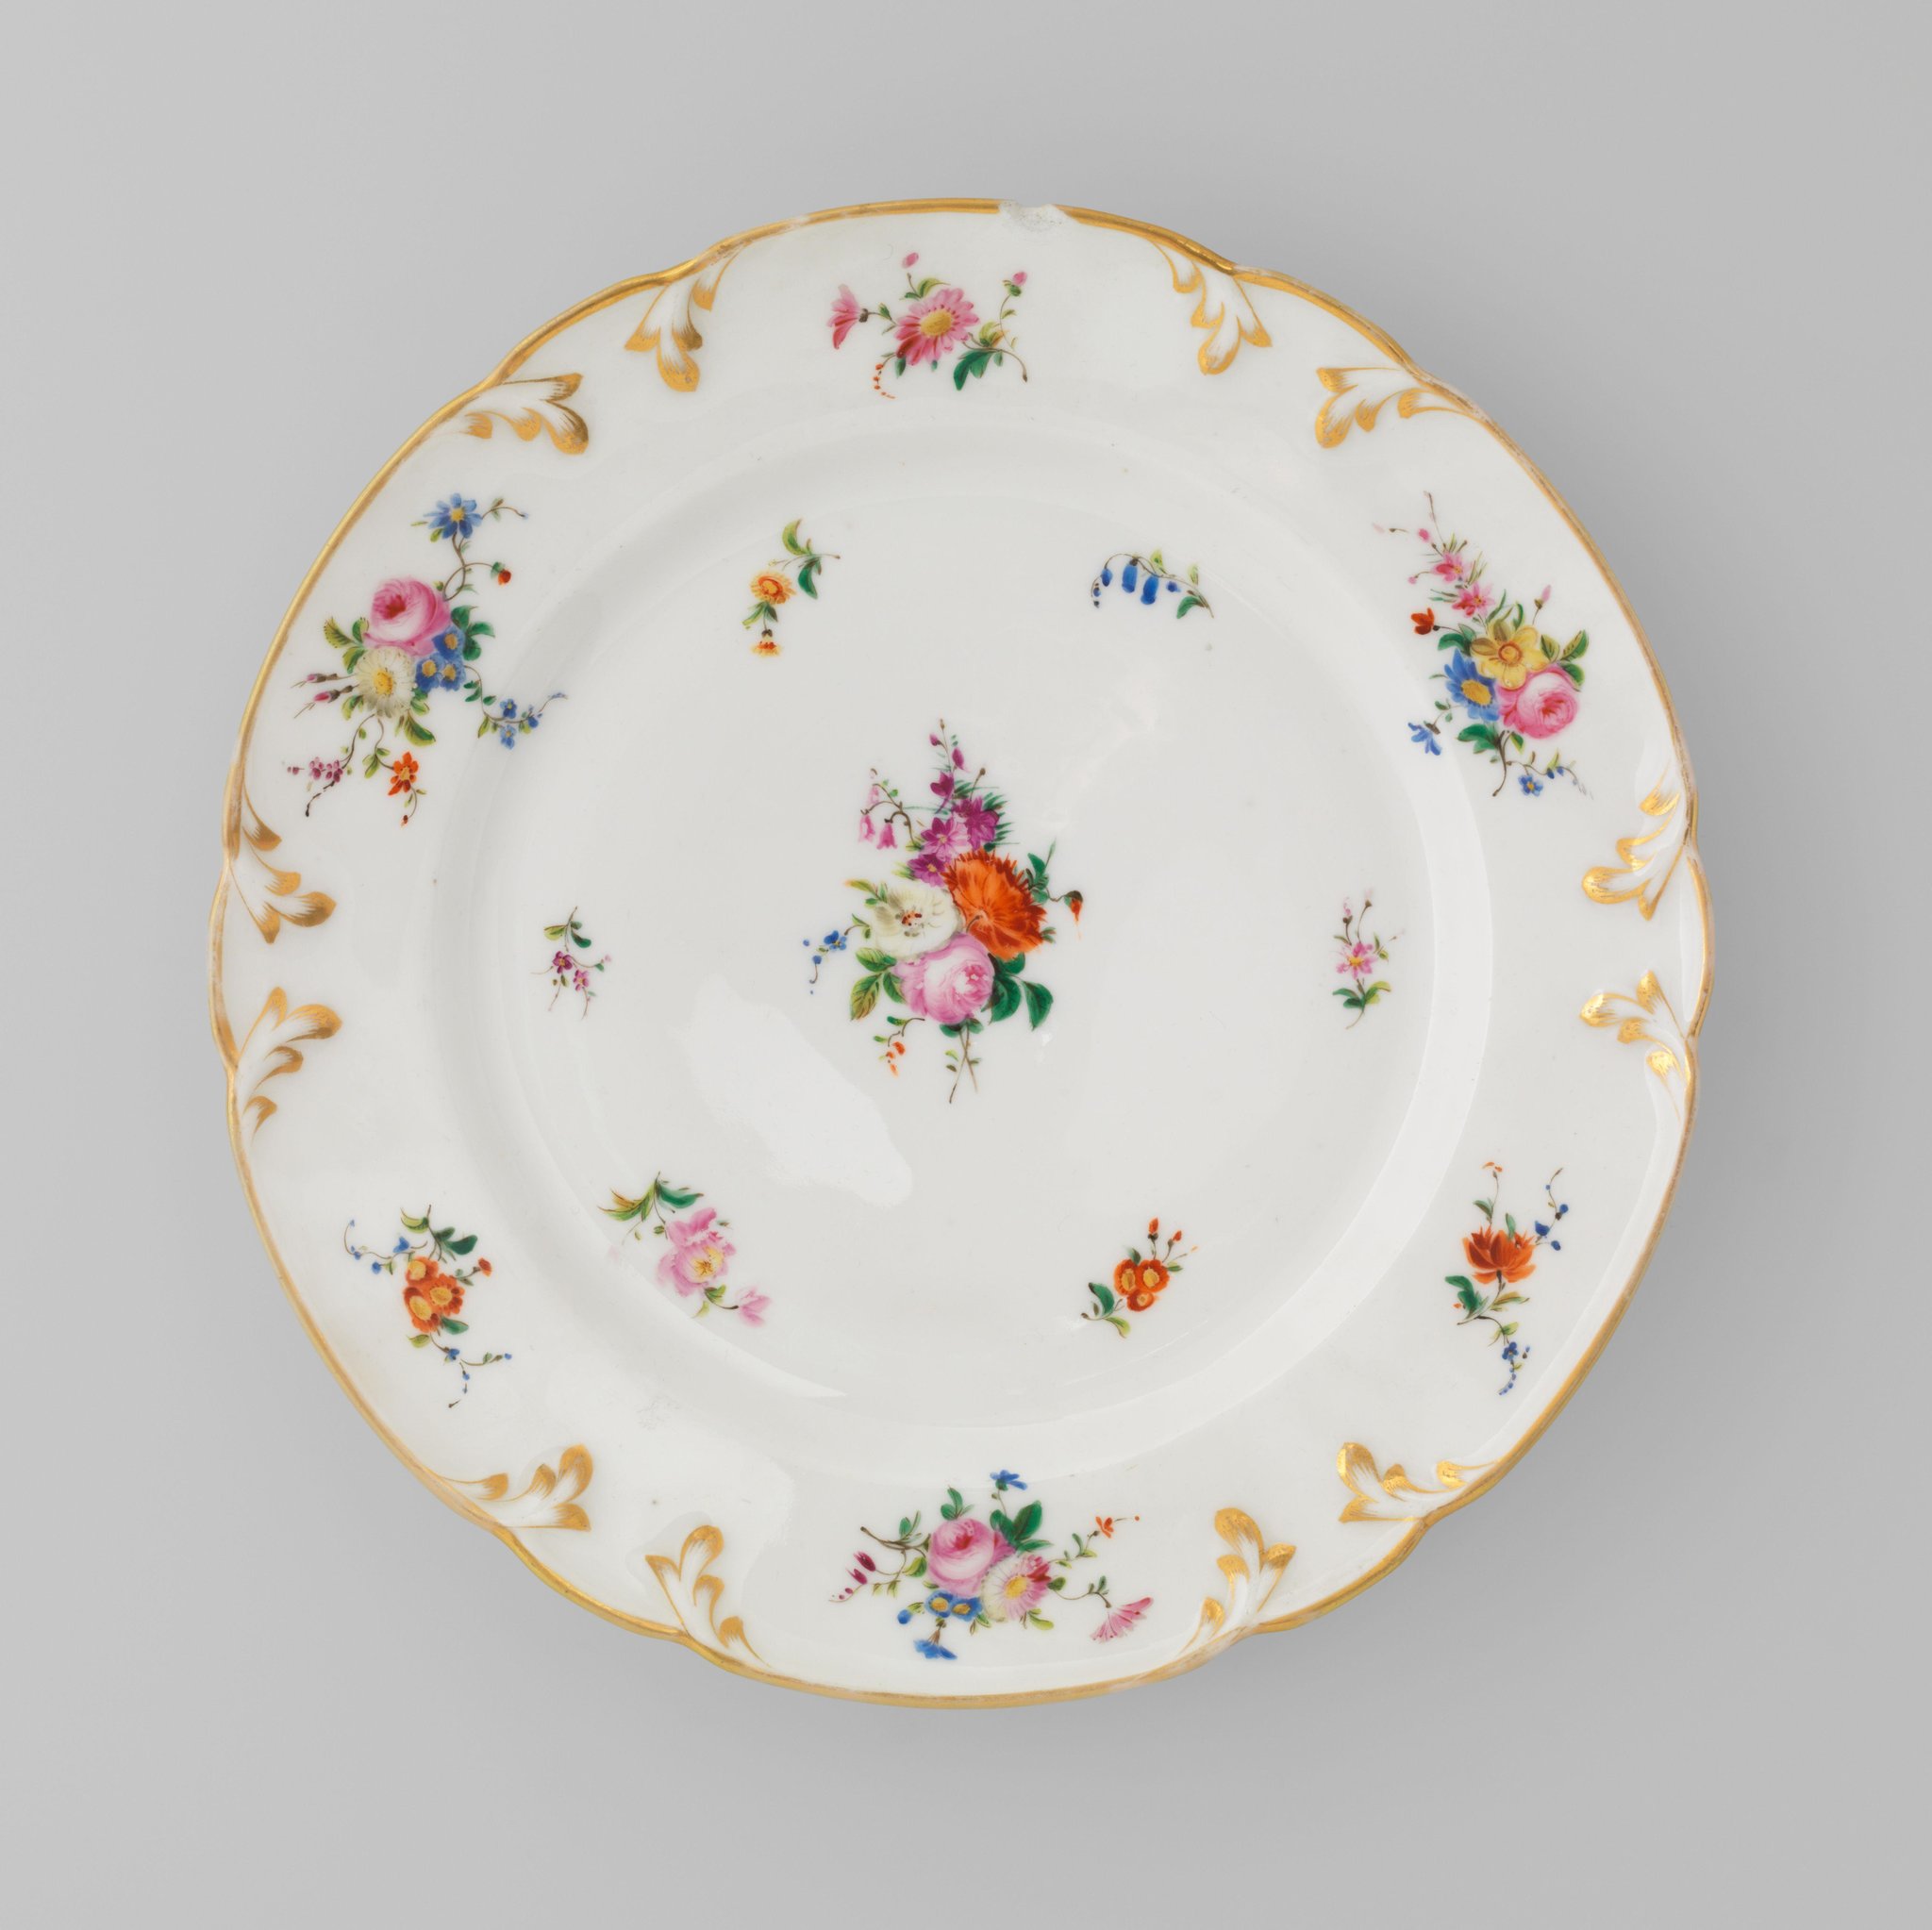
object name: service set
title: Plate with bouquets and flower sprays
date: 1839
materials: glaze, gold, paint, porcelain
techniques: firing, forming, gilding, turning, vitrification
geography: paris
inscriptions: mark: ‘3’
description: Bord van porselein met een gelobde rand, beschilderd op het glazuur in blauw, rood, roze, groen, geel, paars, zwart en goud. Op het plat boeketten van verschillende bloemen en strooibloemen. Vanuit de gelobde, gouden rand, gemodelleerde bladranken in reliëf, aangezet met goud. Hiertussen boeketten. Drie proenen op de onderzijde. Gemerkt op de onderzijde met 3.